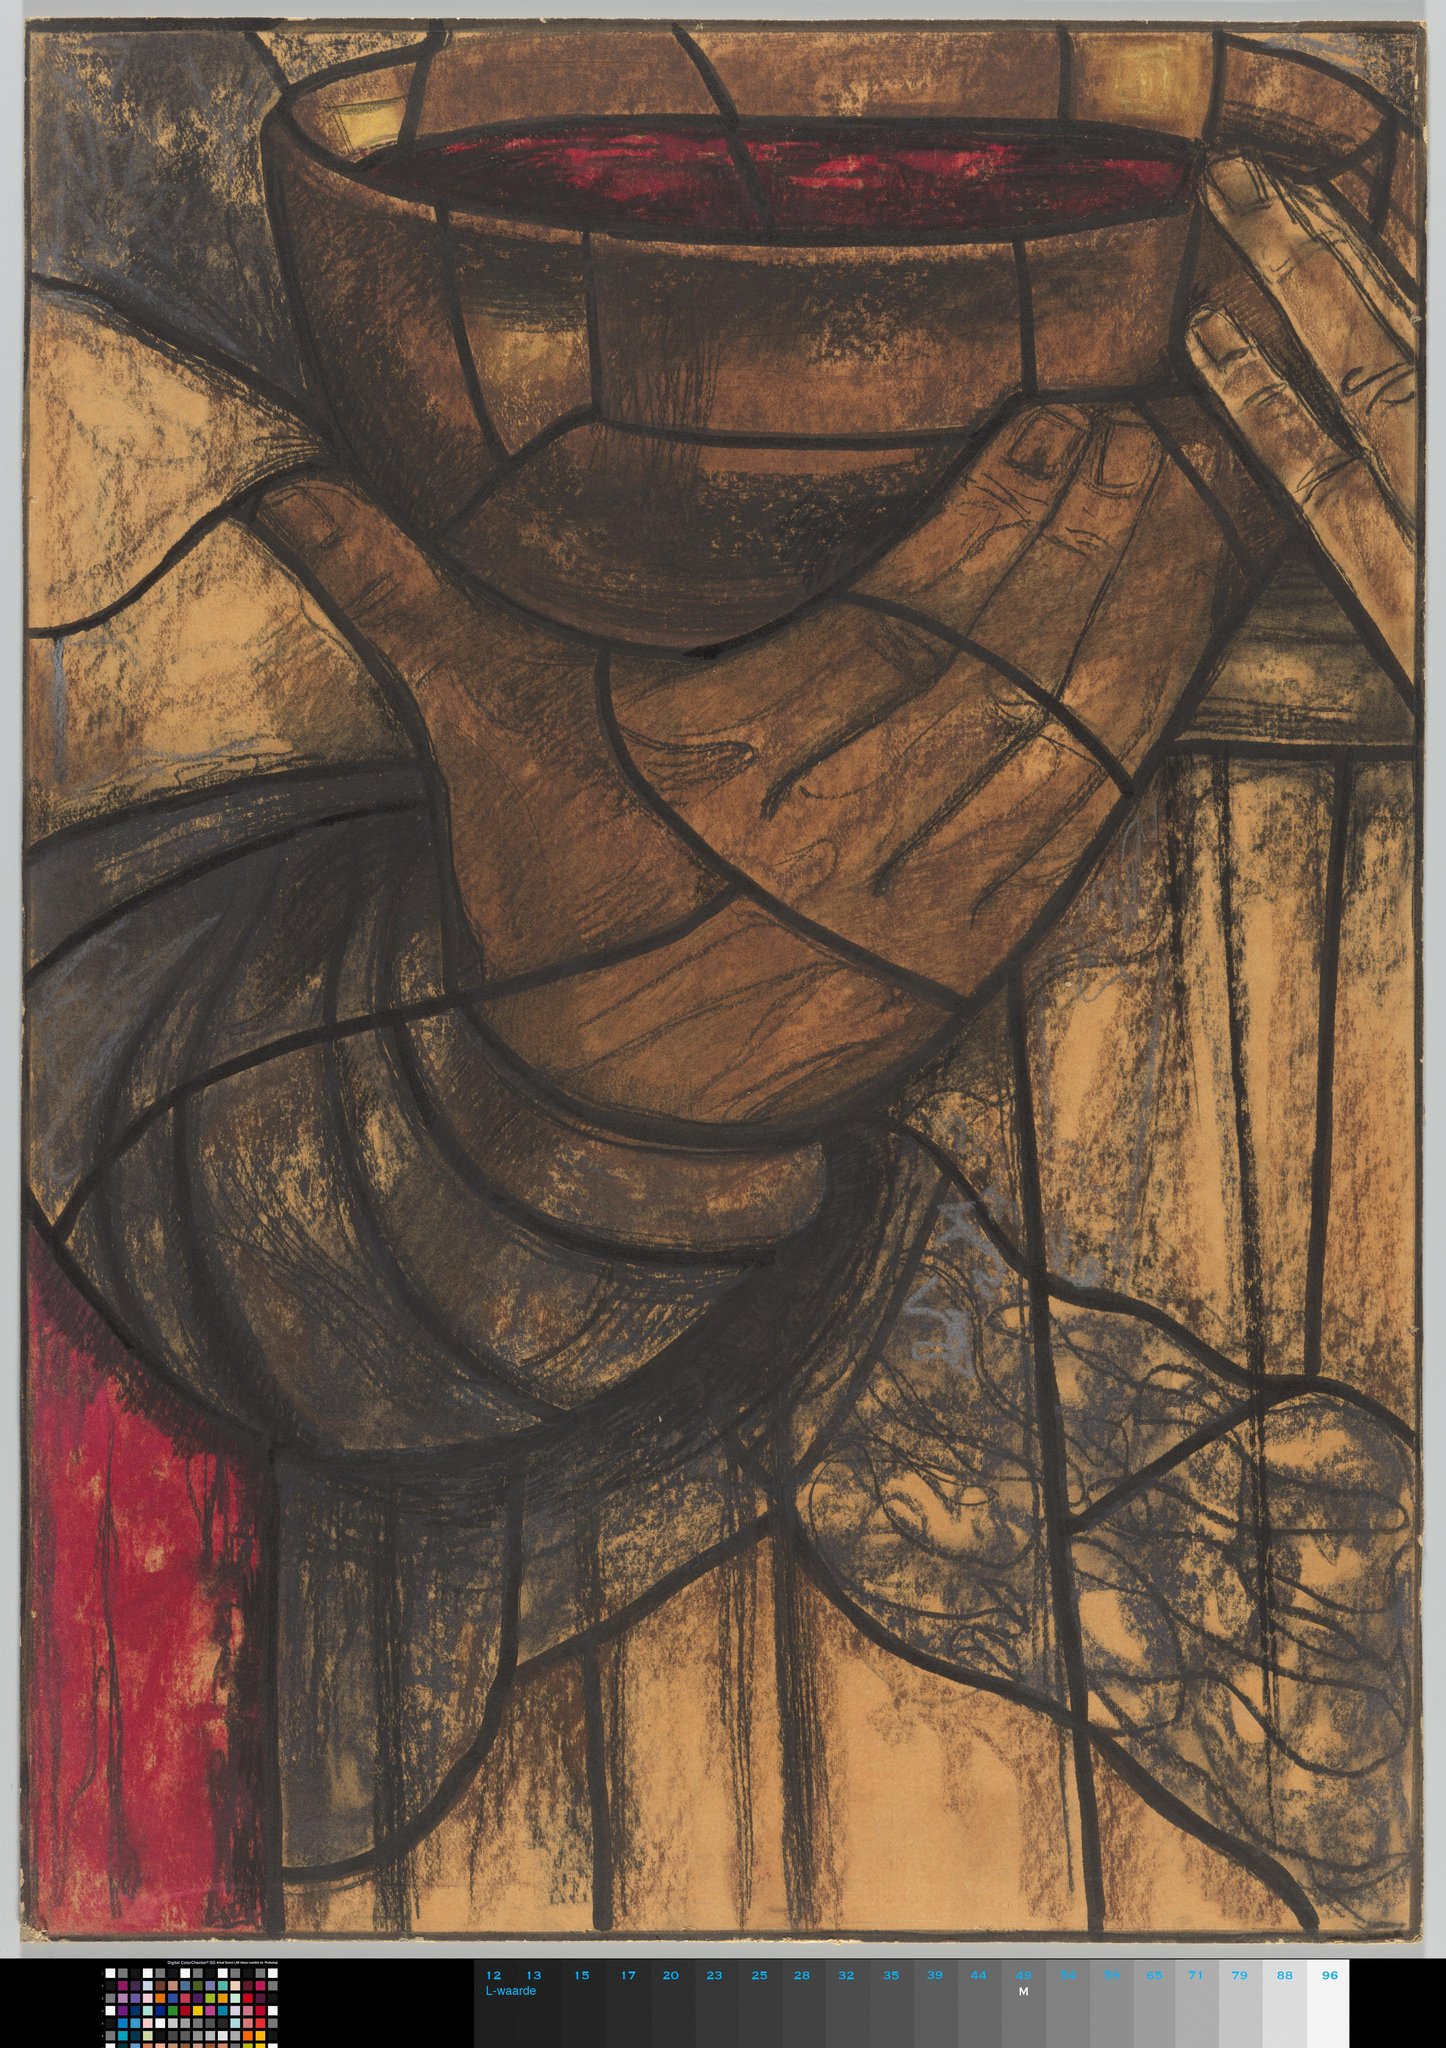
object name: design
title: Ontwerp voor raam in het Noordertransept in de Dom te Utrecht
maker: richard nicolaüs roland holst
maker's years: 1868-1938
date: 1934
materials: cardboard, chalk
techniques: brush